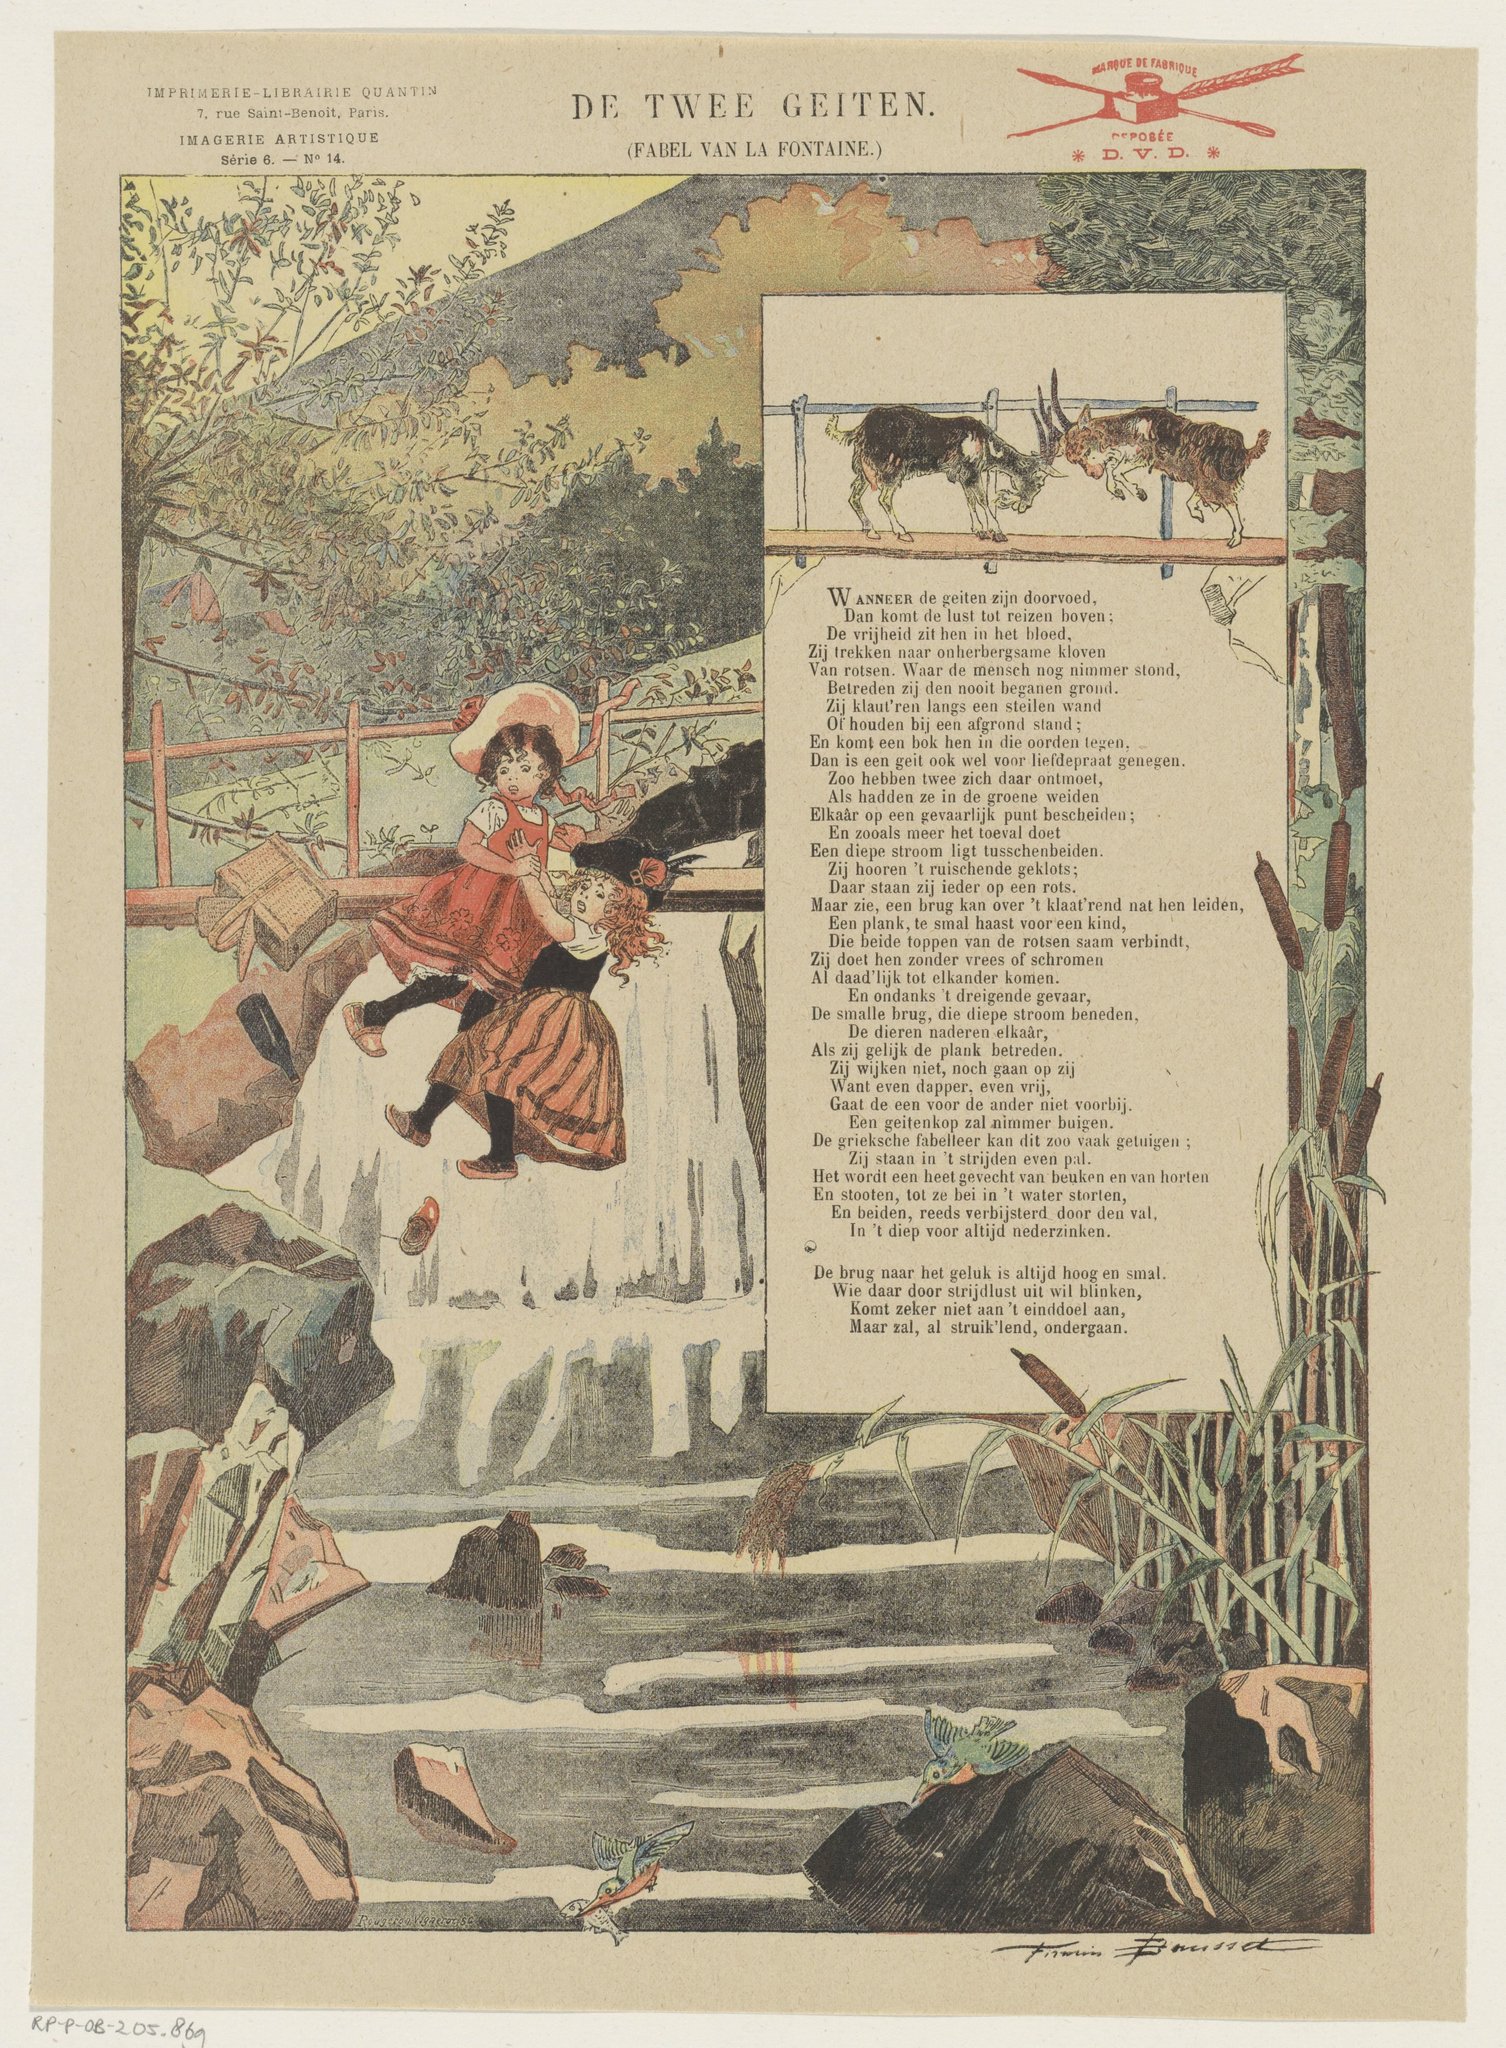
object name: popular print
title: Fabel van La Fontaine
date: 1876-1890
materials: paper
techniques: lithograph, letterpress printing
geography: paris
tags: landscape with bridge, viaduct or aqueduct, girl (child between toddler and youth), fables, falling, goat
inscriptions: : ‘marque de fabrique / deposée / * D.V.D. *’, collector's mark: Lugt 2760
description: Blad met een grote voorstelling uit de fabel van Jean de La Fontaine, van de twee geiten. Rechtsboven een tekstblok met een vers. Genummerd linksboven: Série 6. - No. 14.